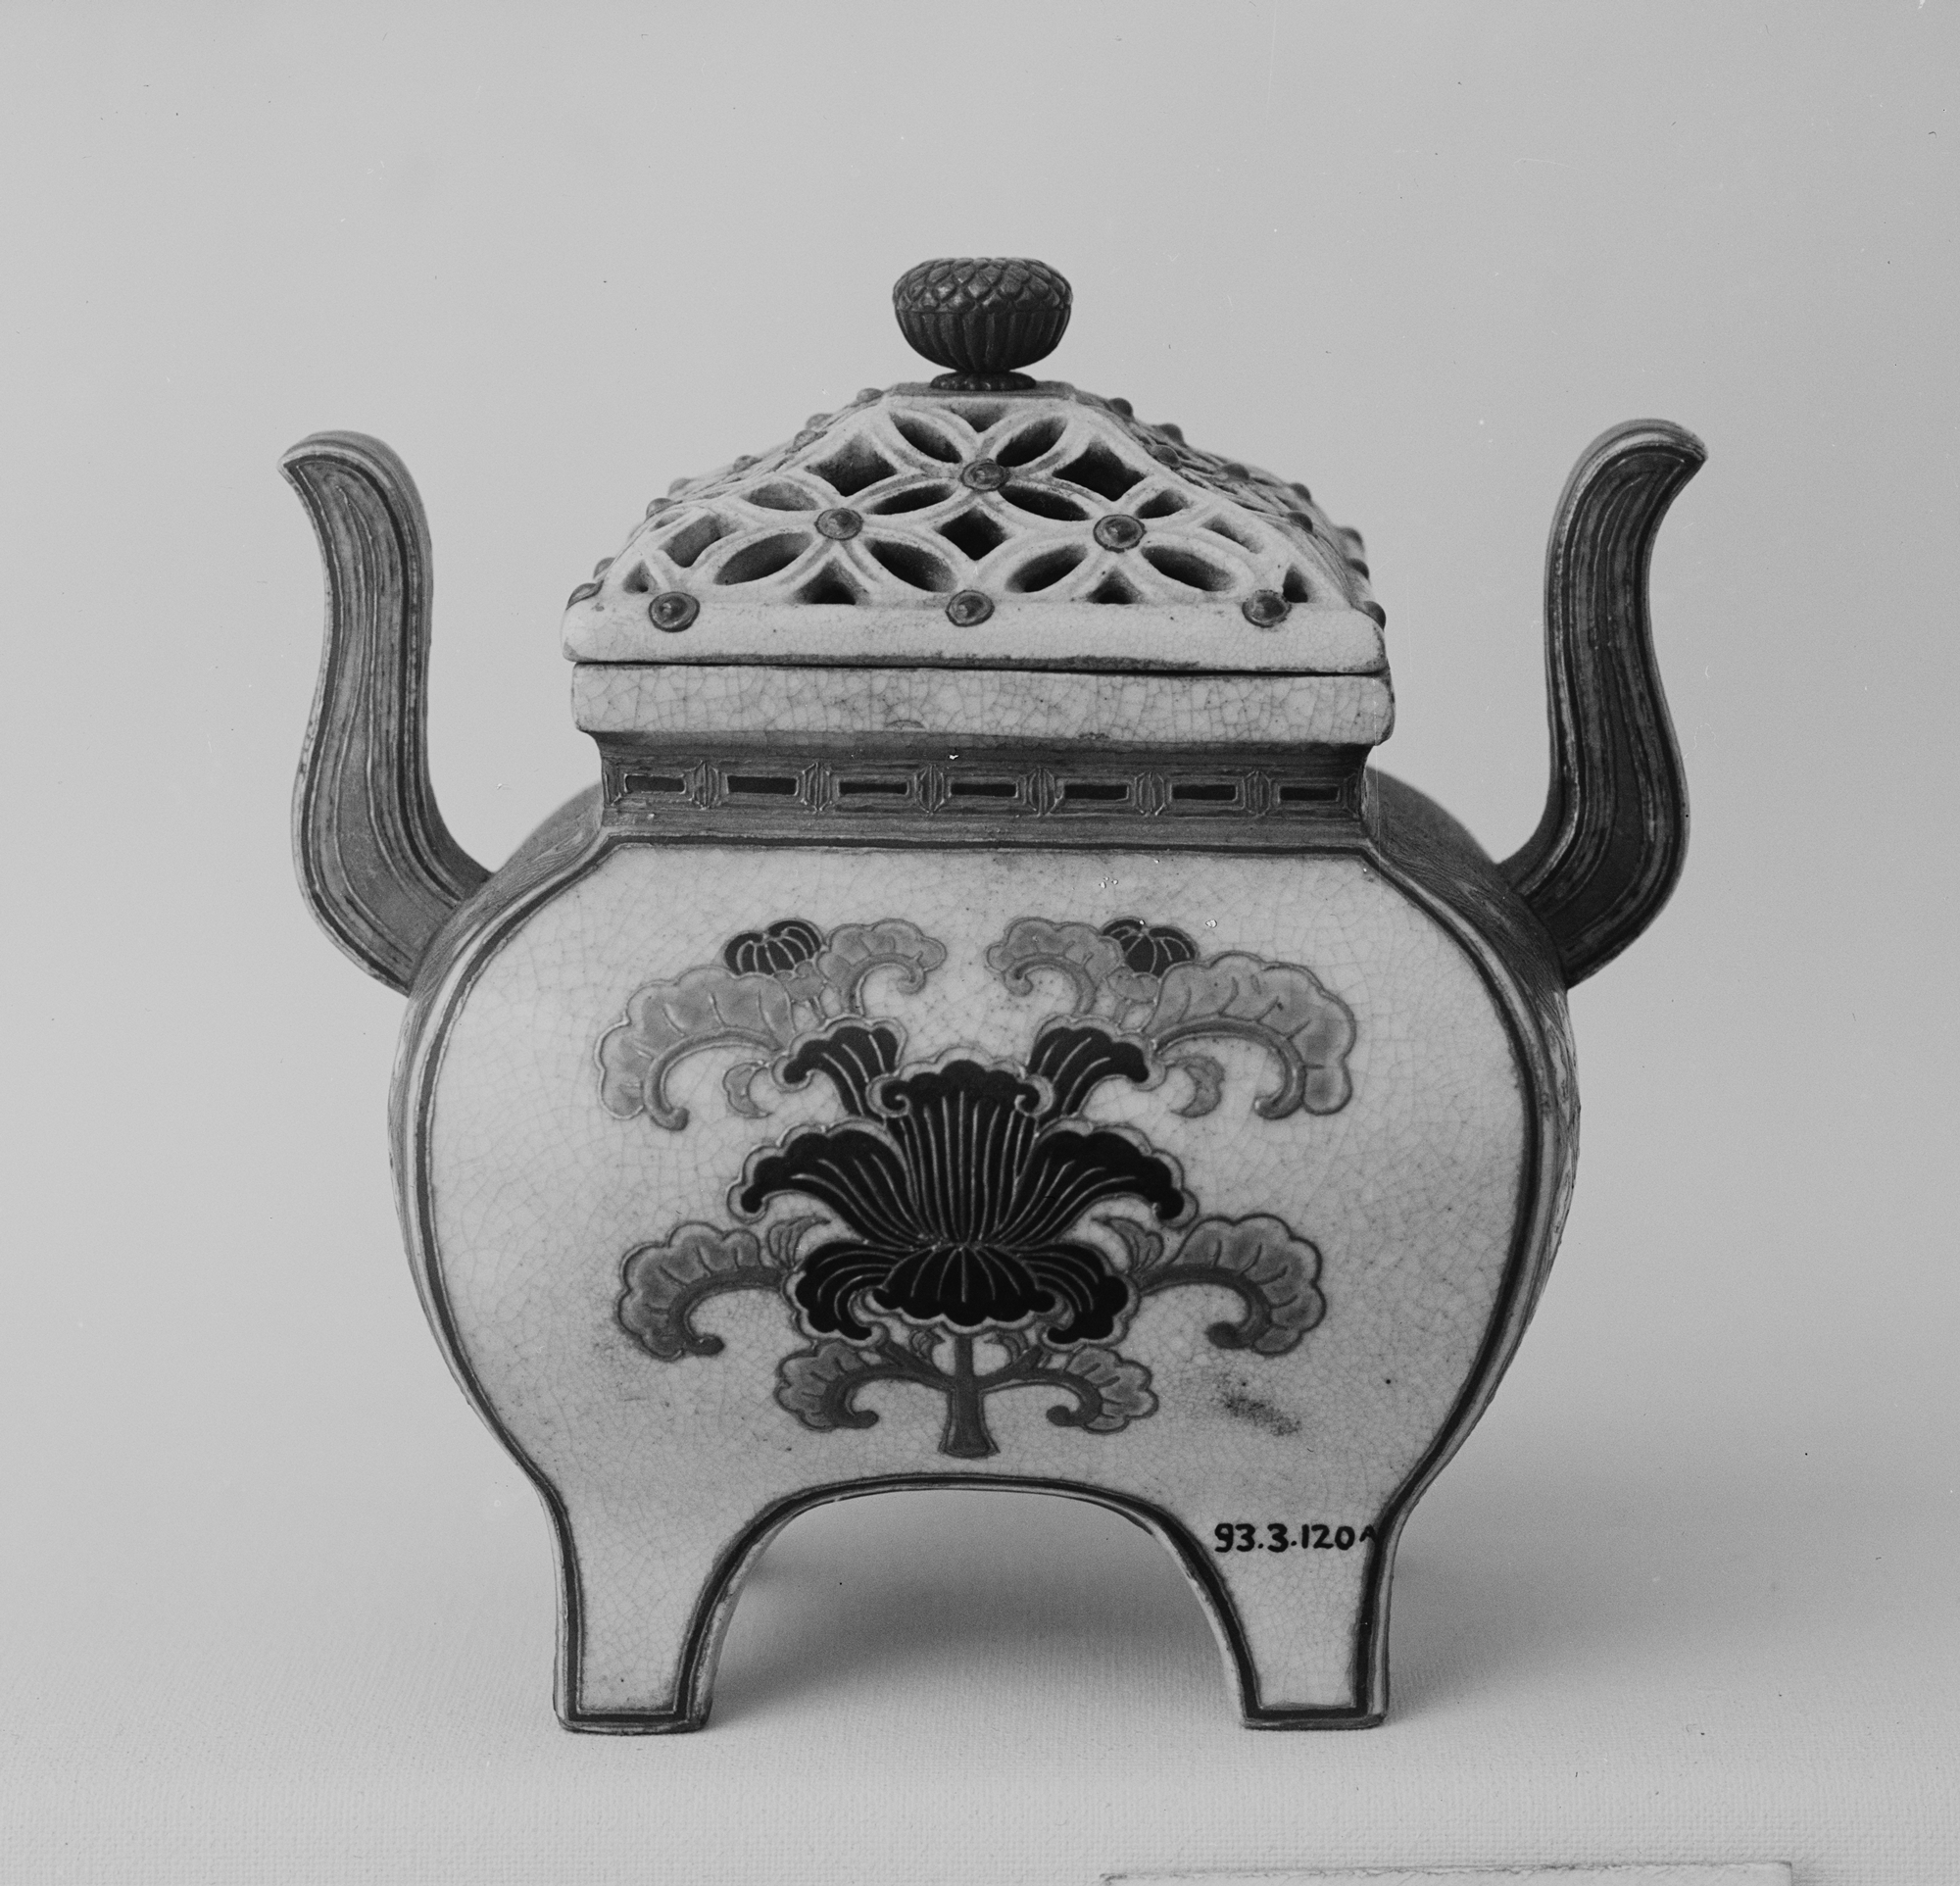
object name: incense burner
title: Incense Burner with Openwork Lid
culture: japanese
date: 1800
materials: clay, enamel, glaze, gold